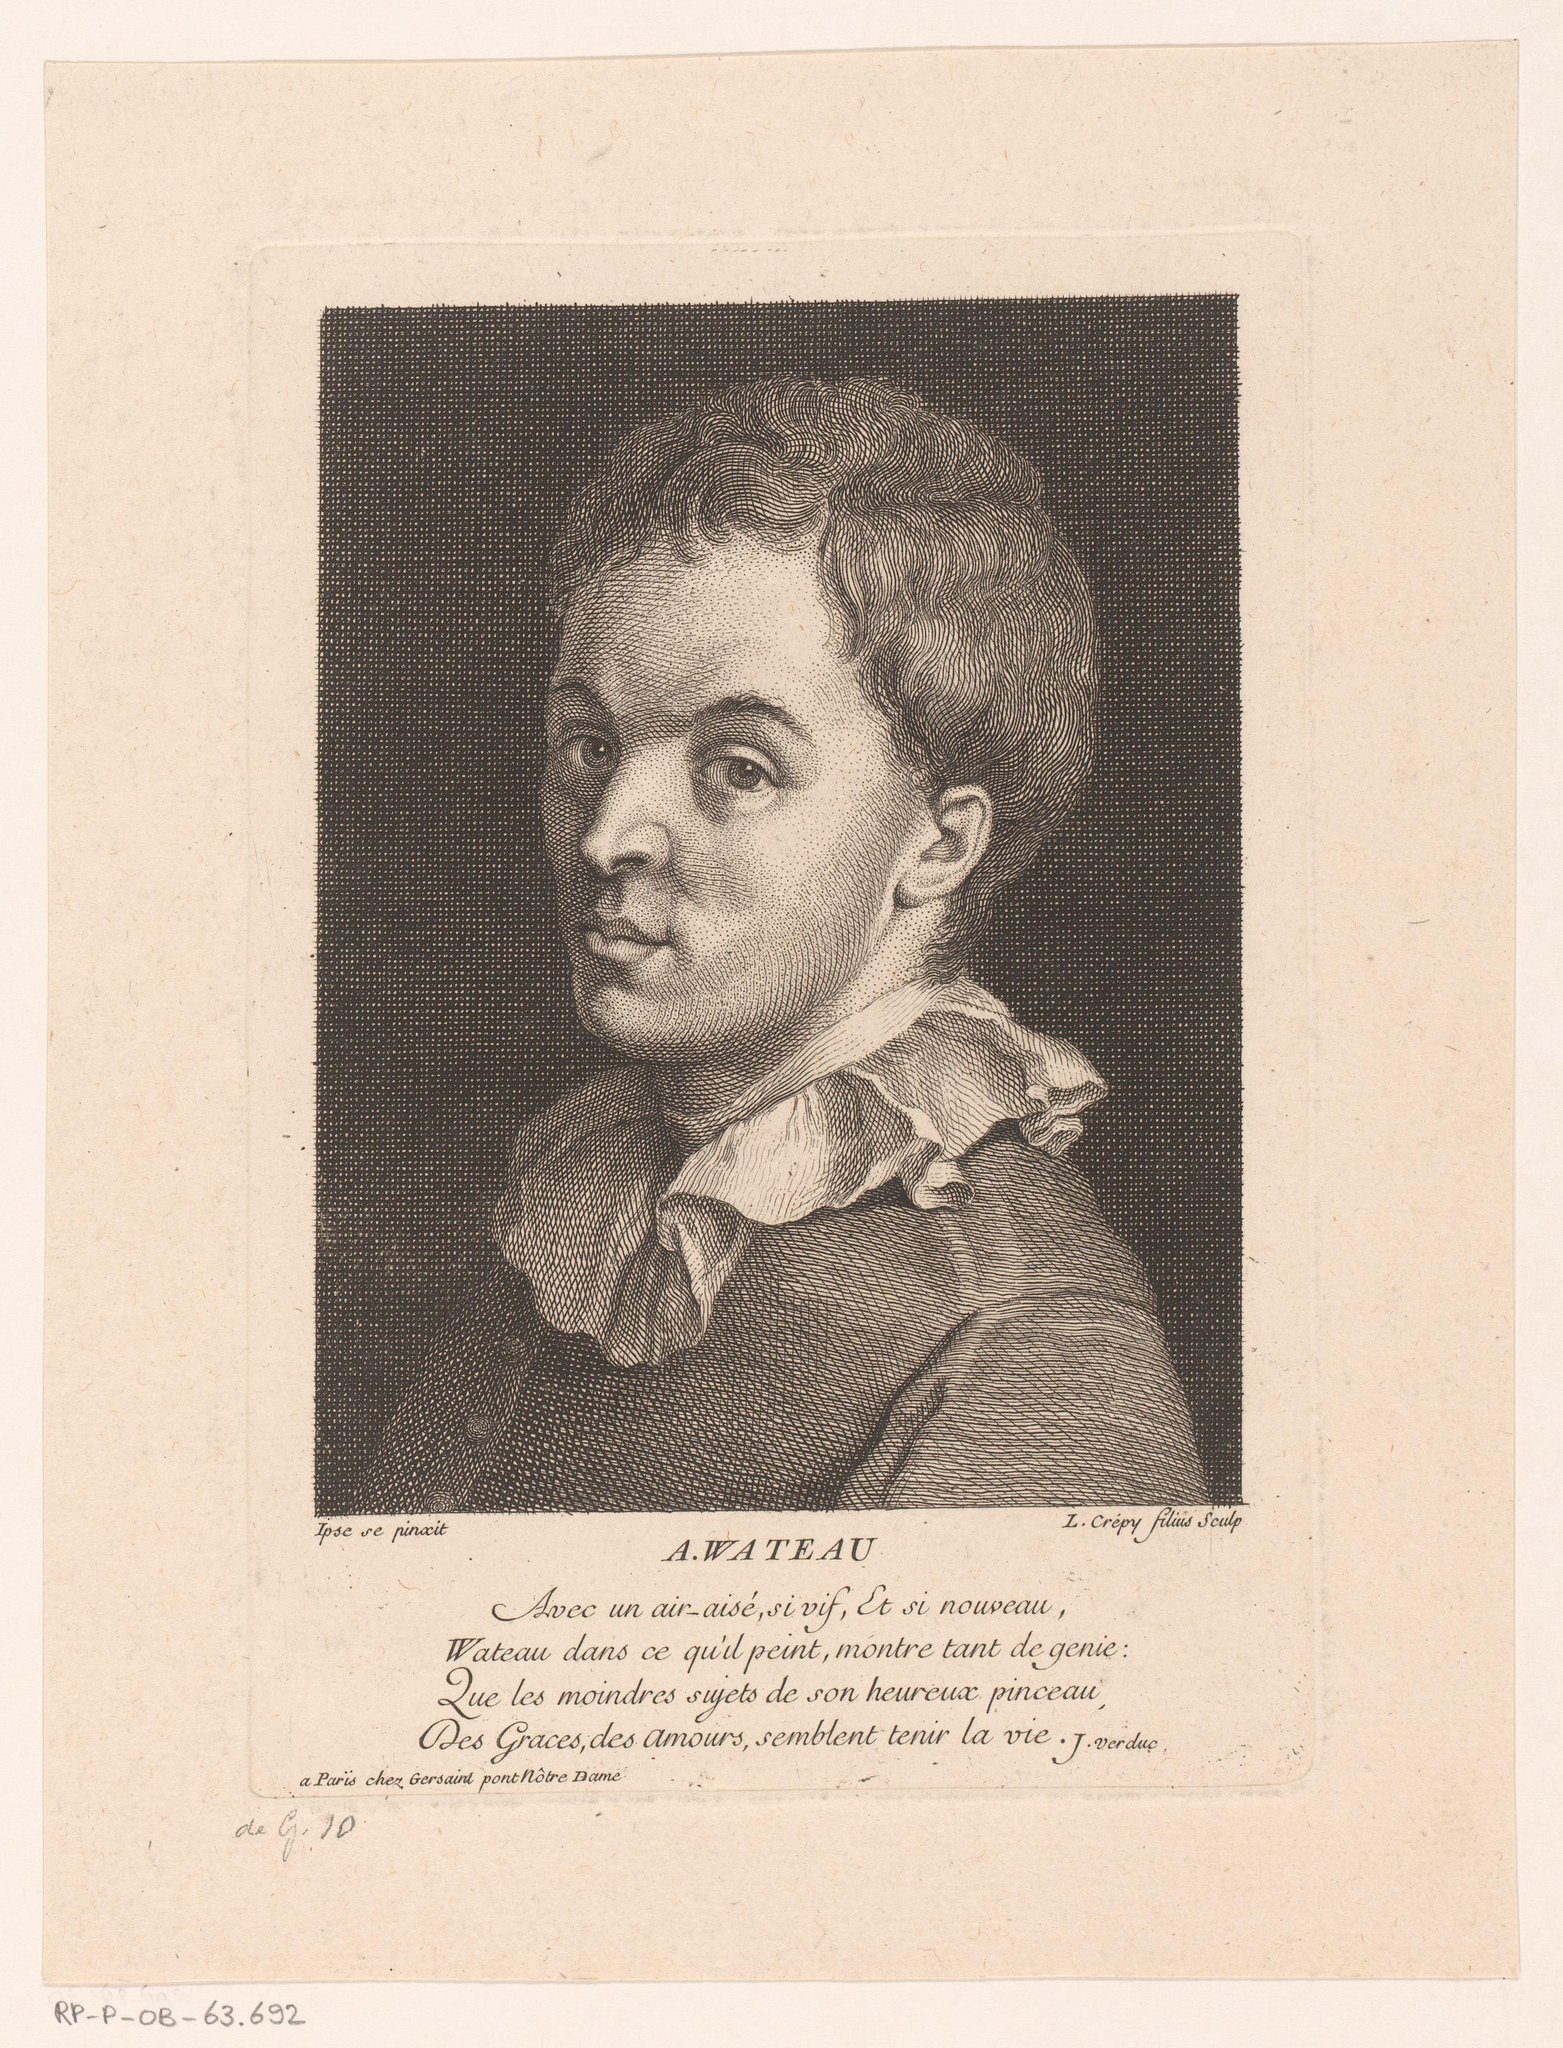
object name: print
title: Portret van Jean Antoine Watteau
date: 1727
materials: paper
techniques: engraving, etching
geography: paris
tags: print maker, draughtsman, jean antoine watteau, historical persons, portrait, self-portrait of artist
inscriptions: collector's mark: Lugt 2228